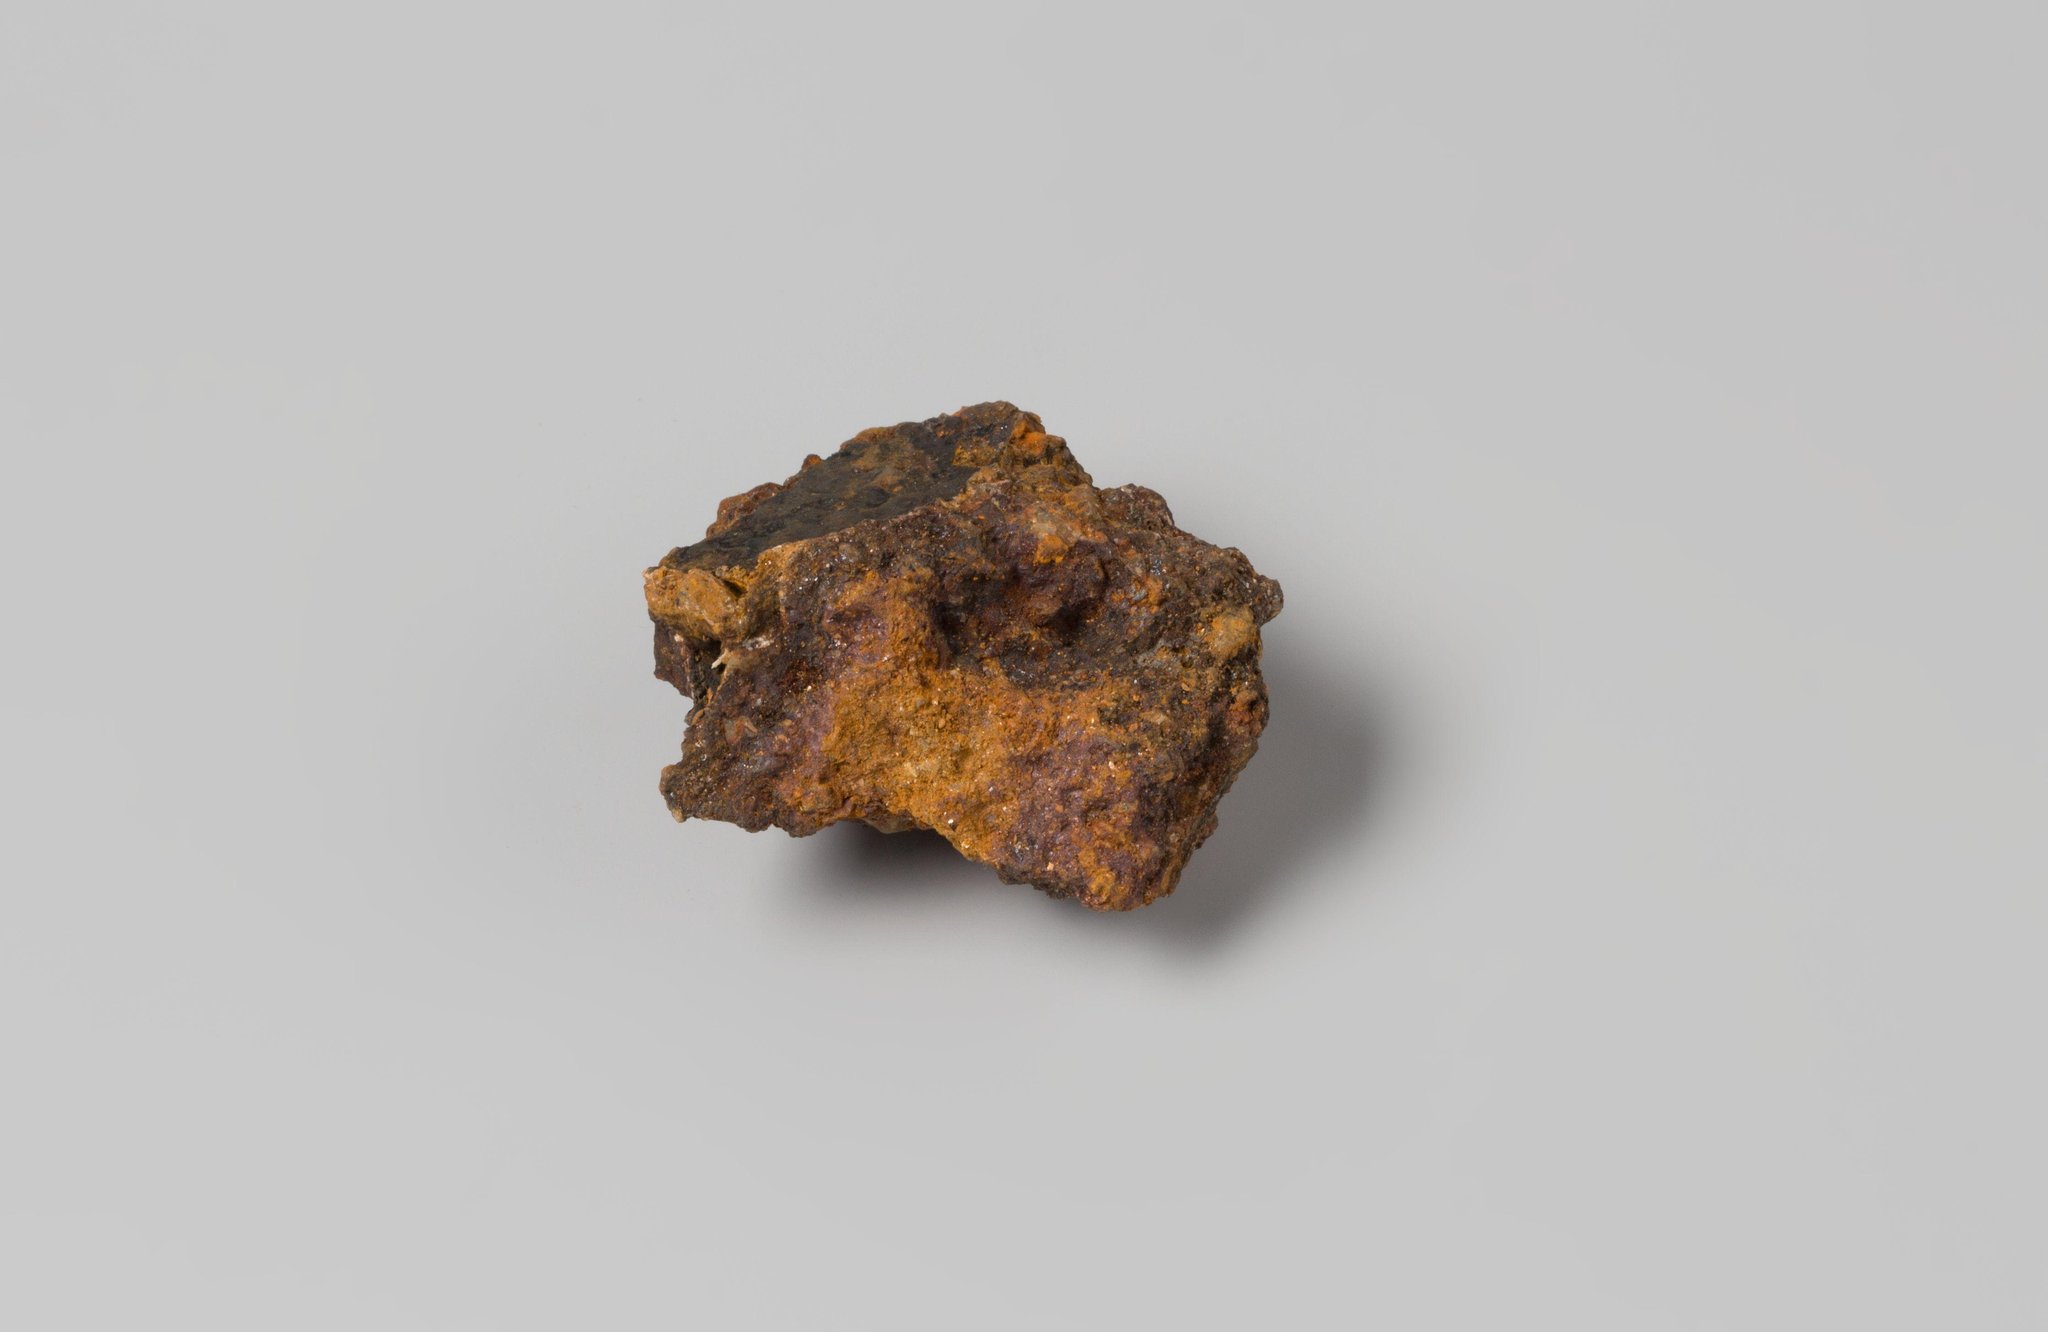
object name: concretionary stone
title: Concretie uit het wrak van de Oost-Indiëvaarder Hollandia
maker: Anonymous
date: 1700-1743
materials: stone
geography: netherlands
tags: verenigde oostindische compagnie, hollandia (schip), annet